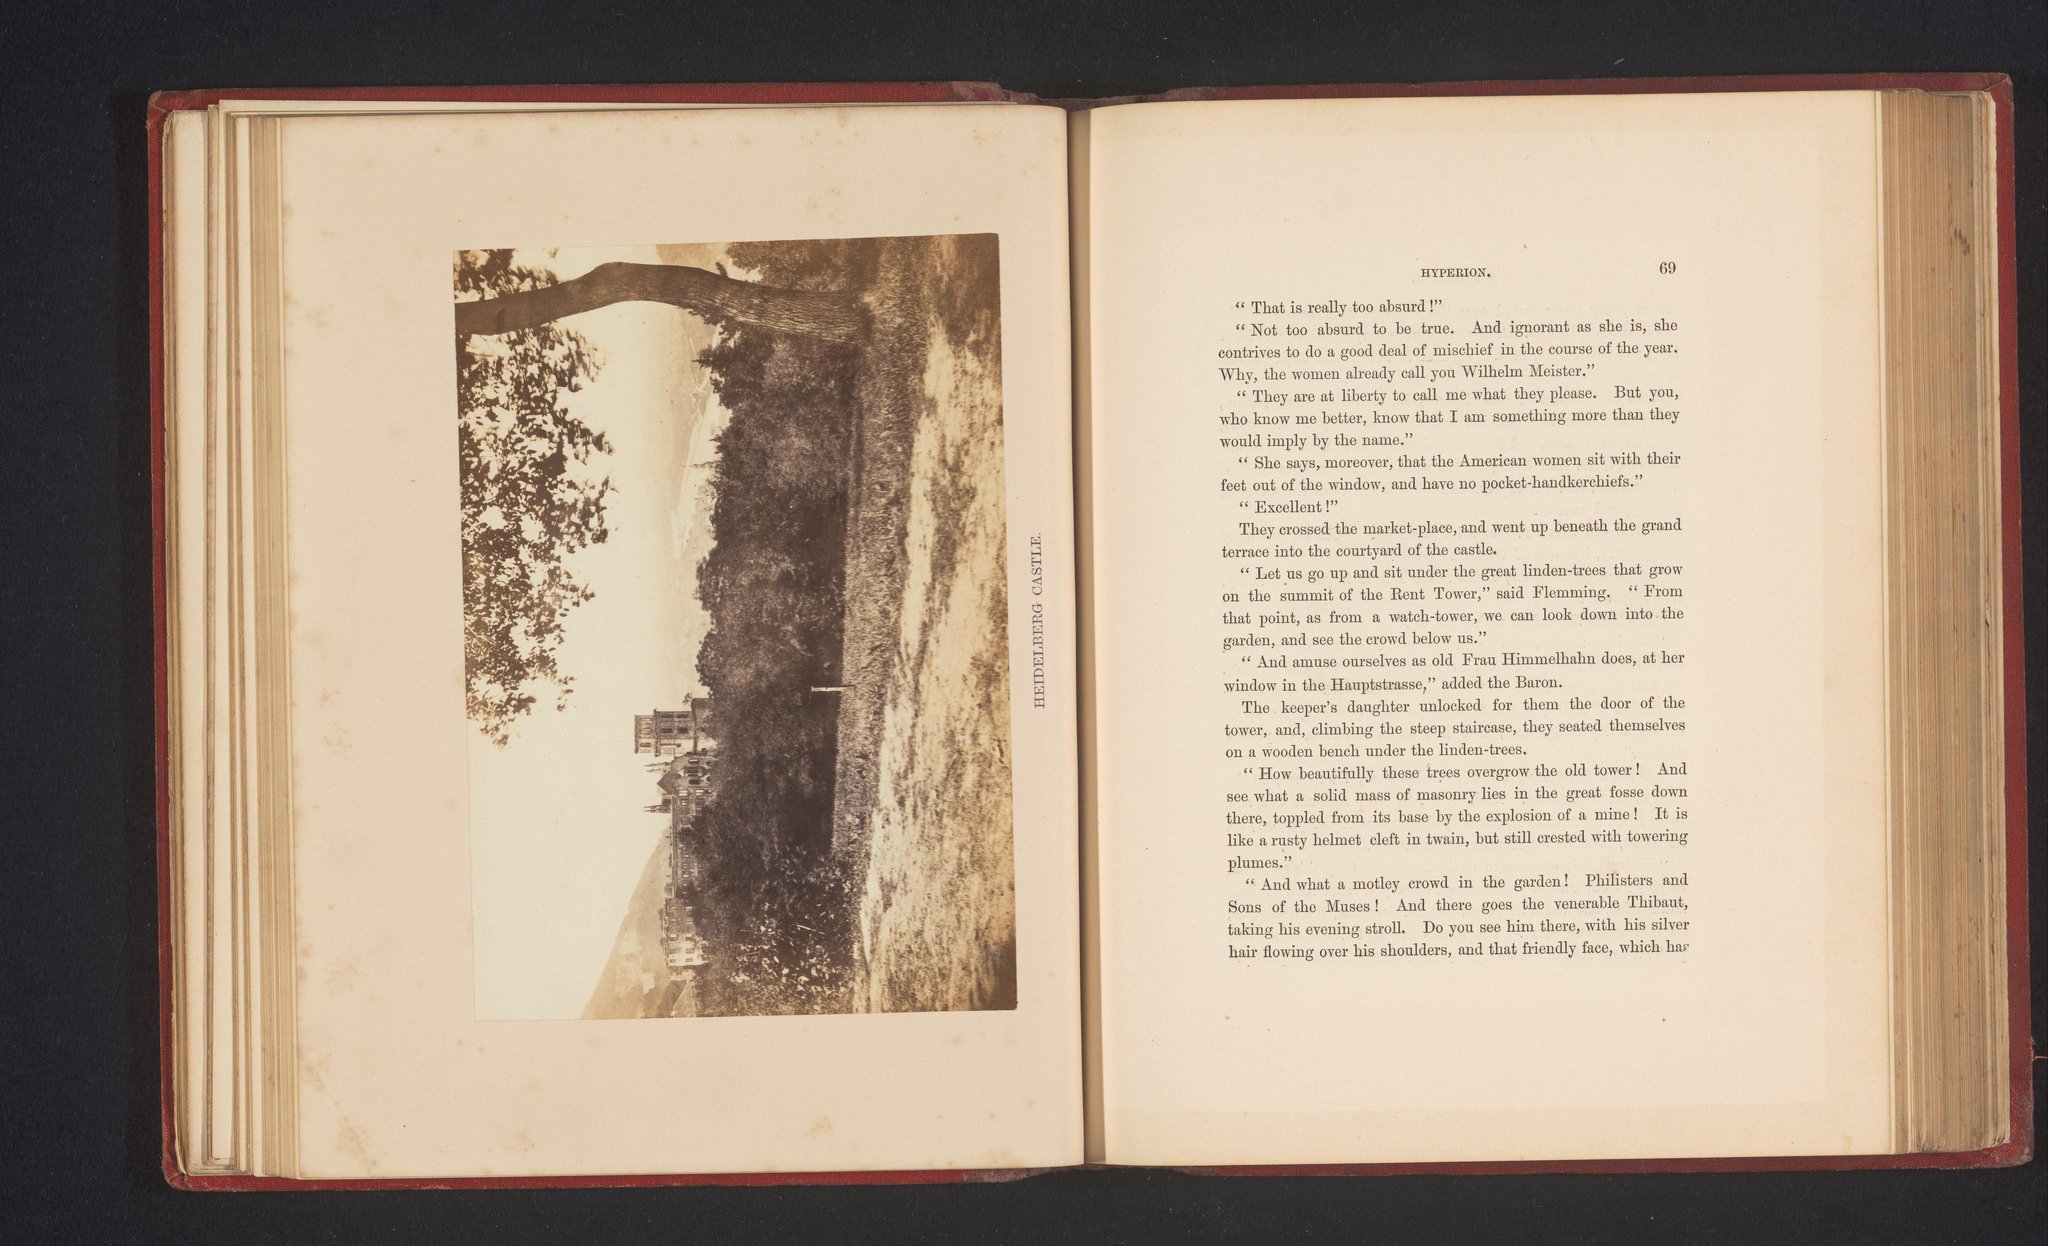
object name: photograph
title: Heidelberg Castle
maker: francis frith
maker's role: publisher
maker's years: 1822-1898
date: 1855-1865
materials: photographic support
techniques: albumen print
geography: heidelberg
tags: castle